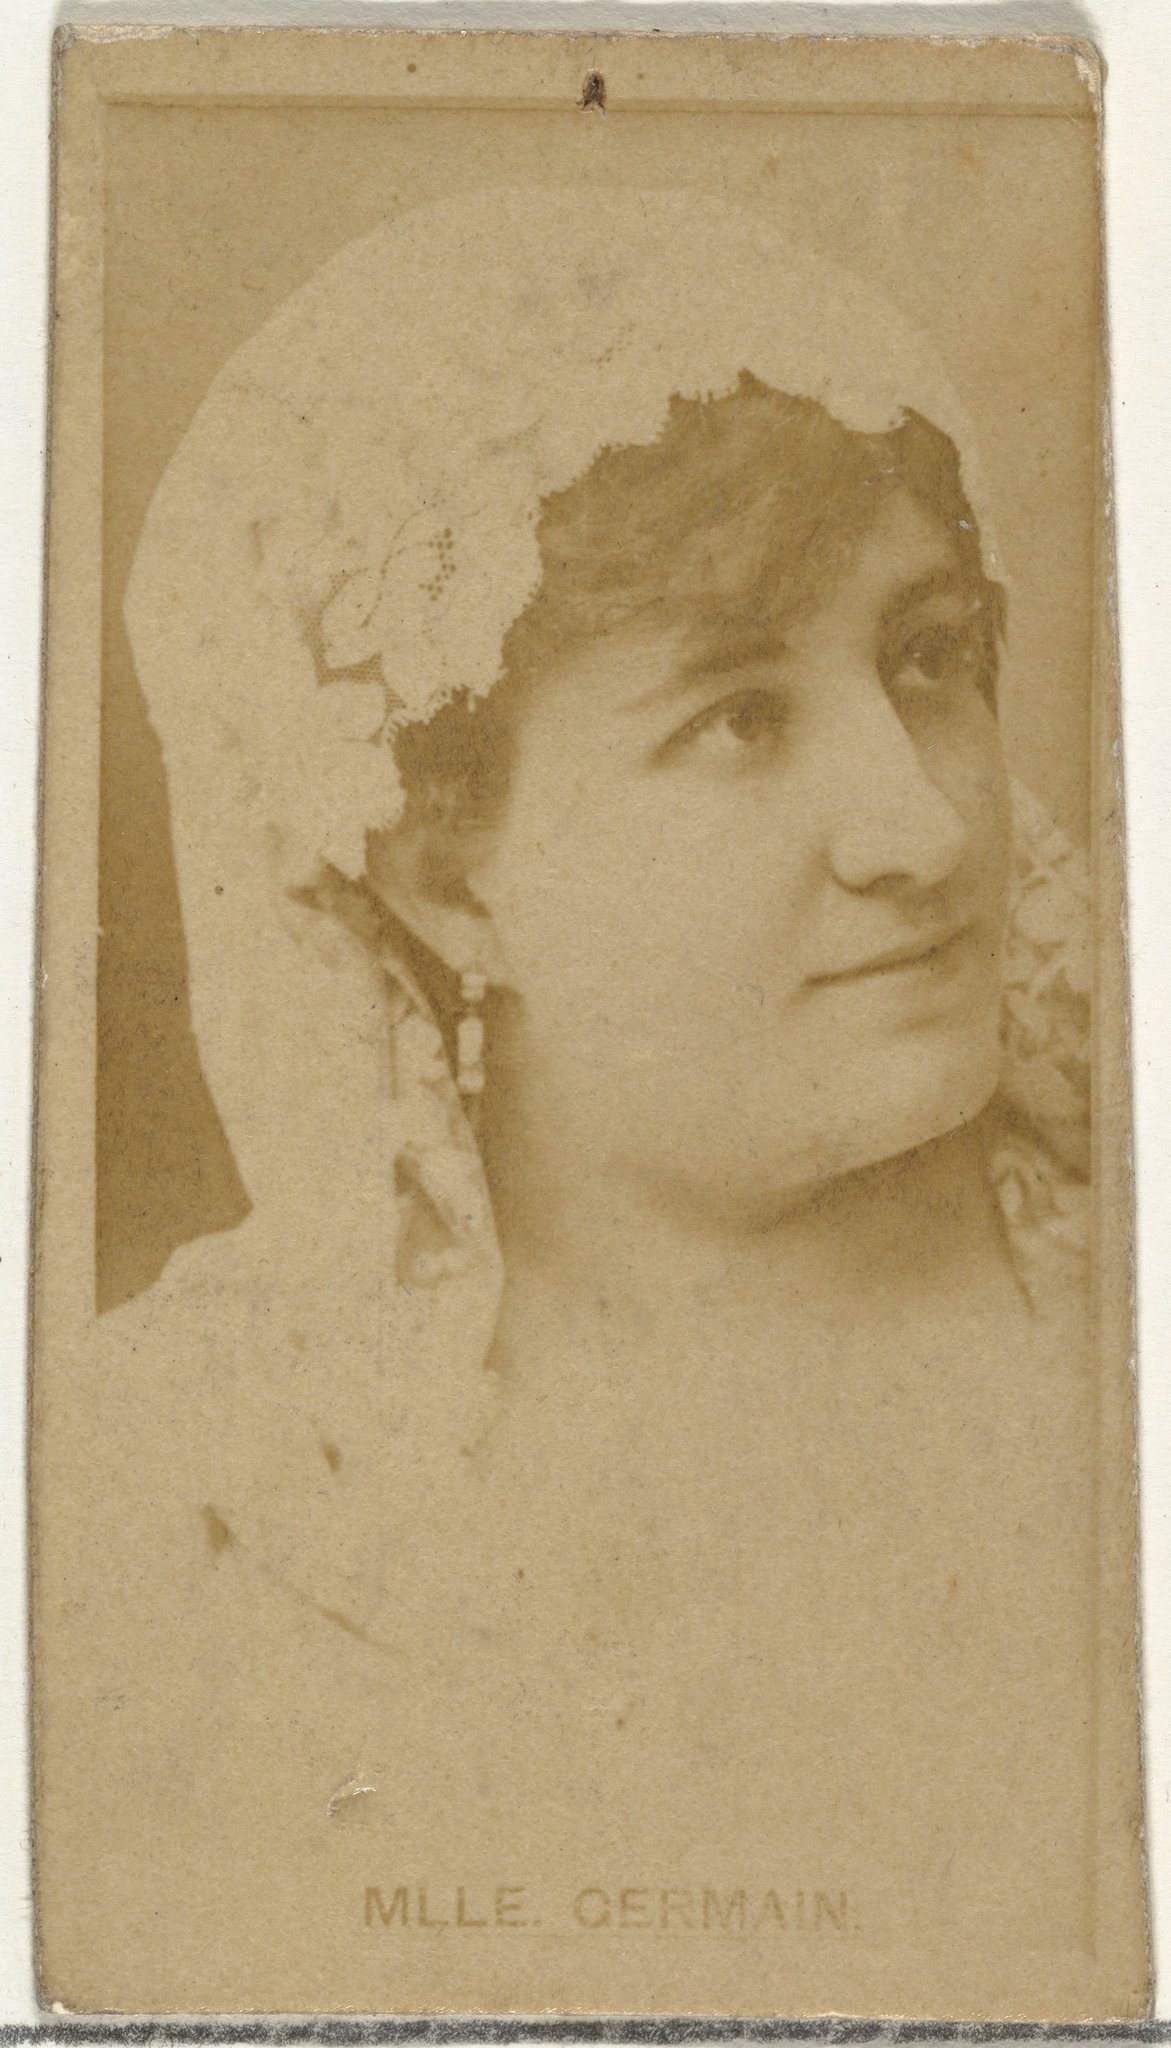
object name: photograph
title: Mlle. Germain, from the Actors and Actresses series (N145-8) issued by Duke Sons & Co. to promote Duke Cigarettes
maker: w. duke, sons & co.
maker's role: publisher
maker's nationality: american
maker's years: 1870-1920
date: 1891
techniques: albumen silver print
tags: portraits,women,actresses